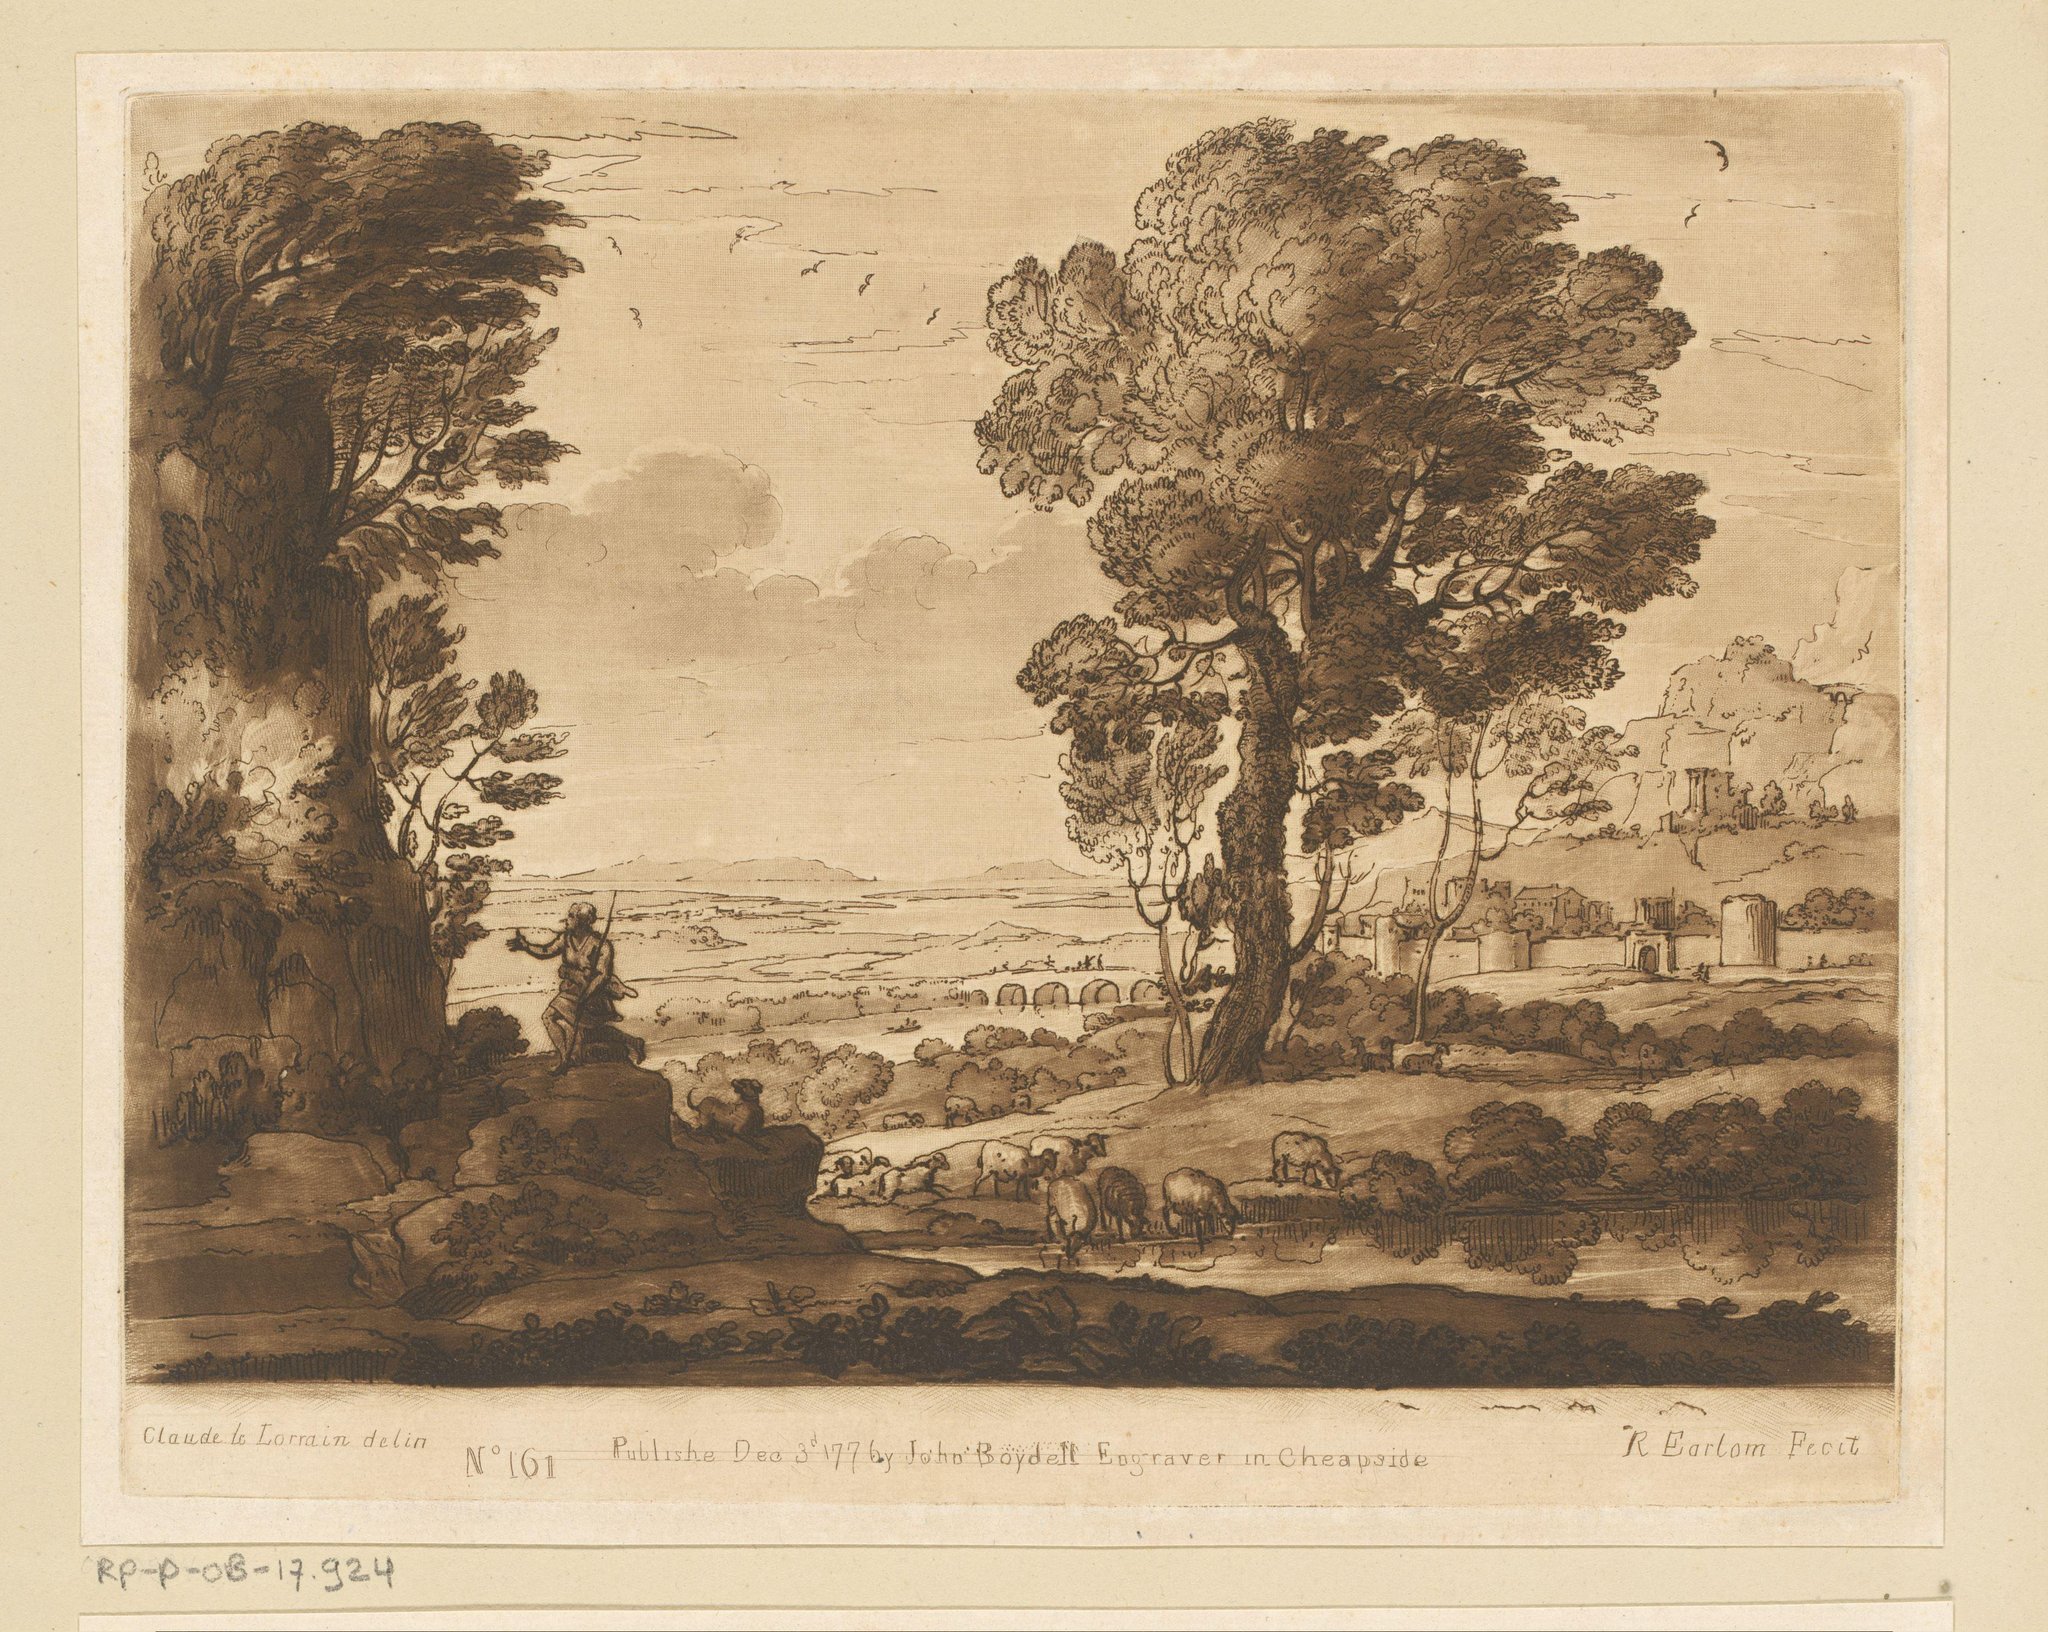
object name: print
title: Prenten naar tekeningen van Claude Lorrain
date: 1776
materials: paper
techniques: etching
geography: london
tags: river - hh - ideal landscapes, city-view, and landscape with man-made constructions - ii - ideal landscapes, moses, kneeling before the bush and hiding his face, listens to god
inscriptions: date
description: Vanaf 1774 publiceerde John Boydell tweehonderd prenten naar het tekeningenboek Liber Veritatis van Claude Lorrain, in het bezit van de hertogen van Cavendish. Deze prenten werden vanaf 1777 in twee volumes gebundeld uitgegeven.